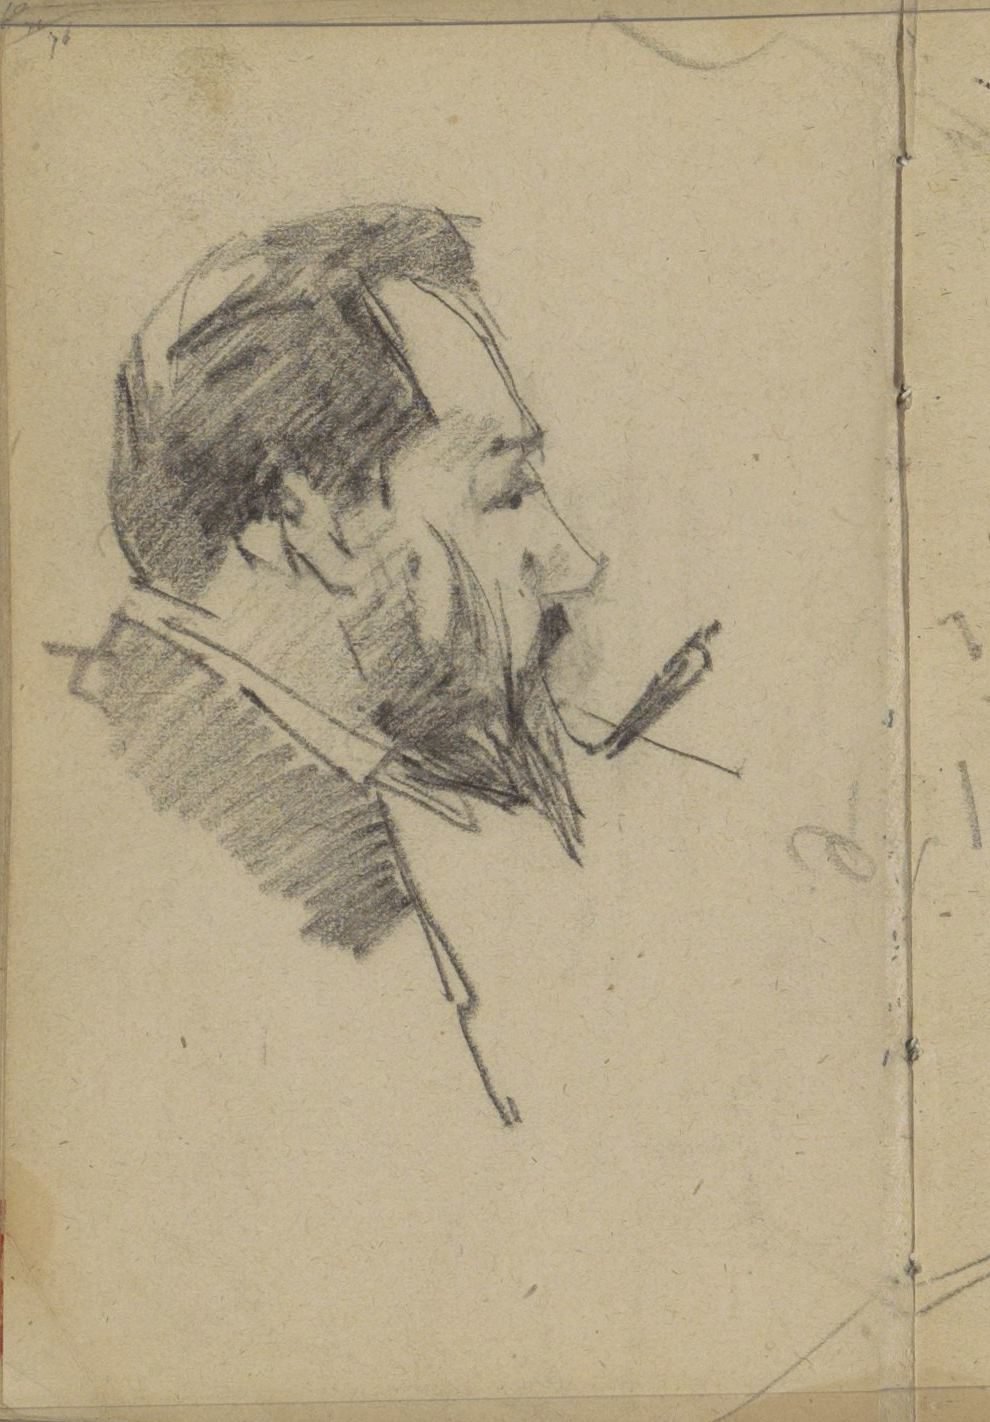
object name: sketchbook leaf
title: Portret van een onbekende man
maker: george hendrik breitner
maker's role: draughtsman, painter, print maker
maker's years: 1857-1923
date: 1881-1883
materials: chalk, paper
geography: south holland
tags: the hague, david adolph constant artz, portrait, self-portrait of artist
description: Portret van een onbekende man, mogelijk David Adolph Constant Artz, in profiel naar rechts. Pagina 76 uit een schetsboek met 70 bladen.